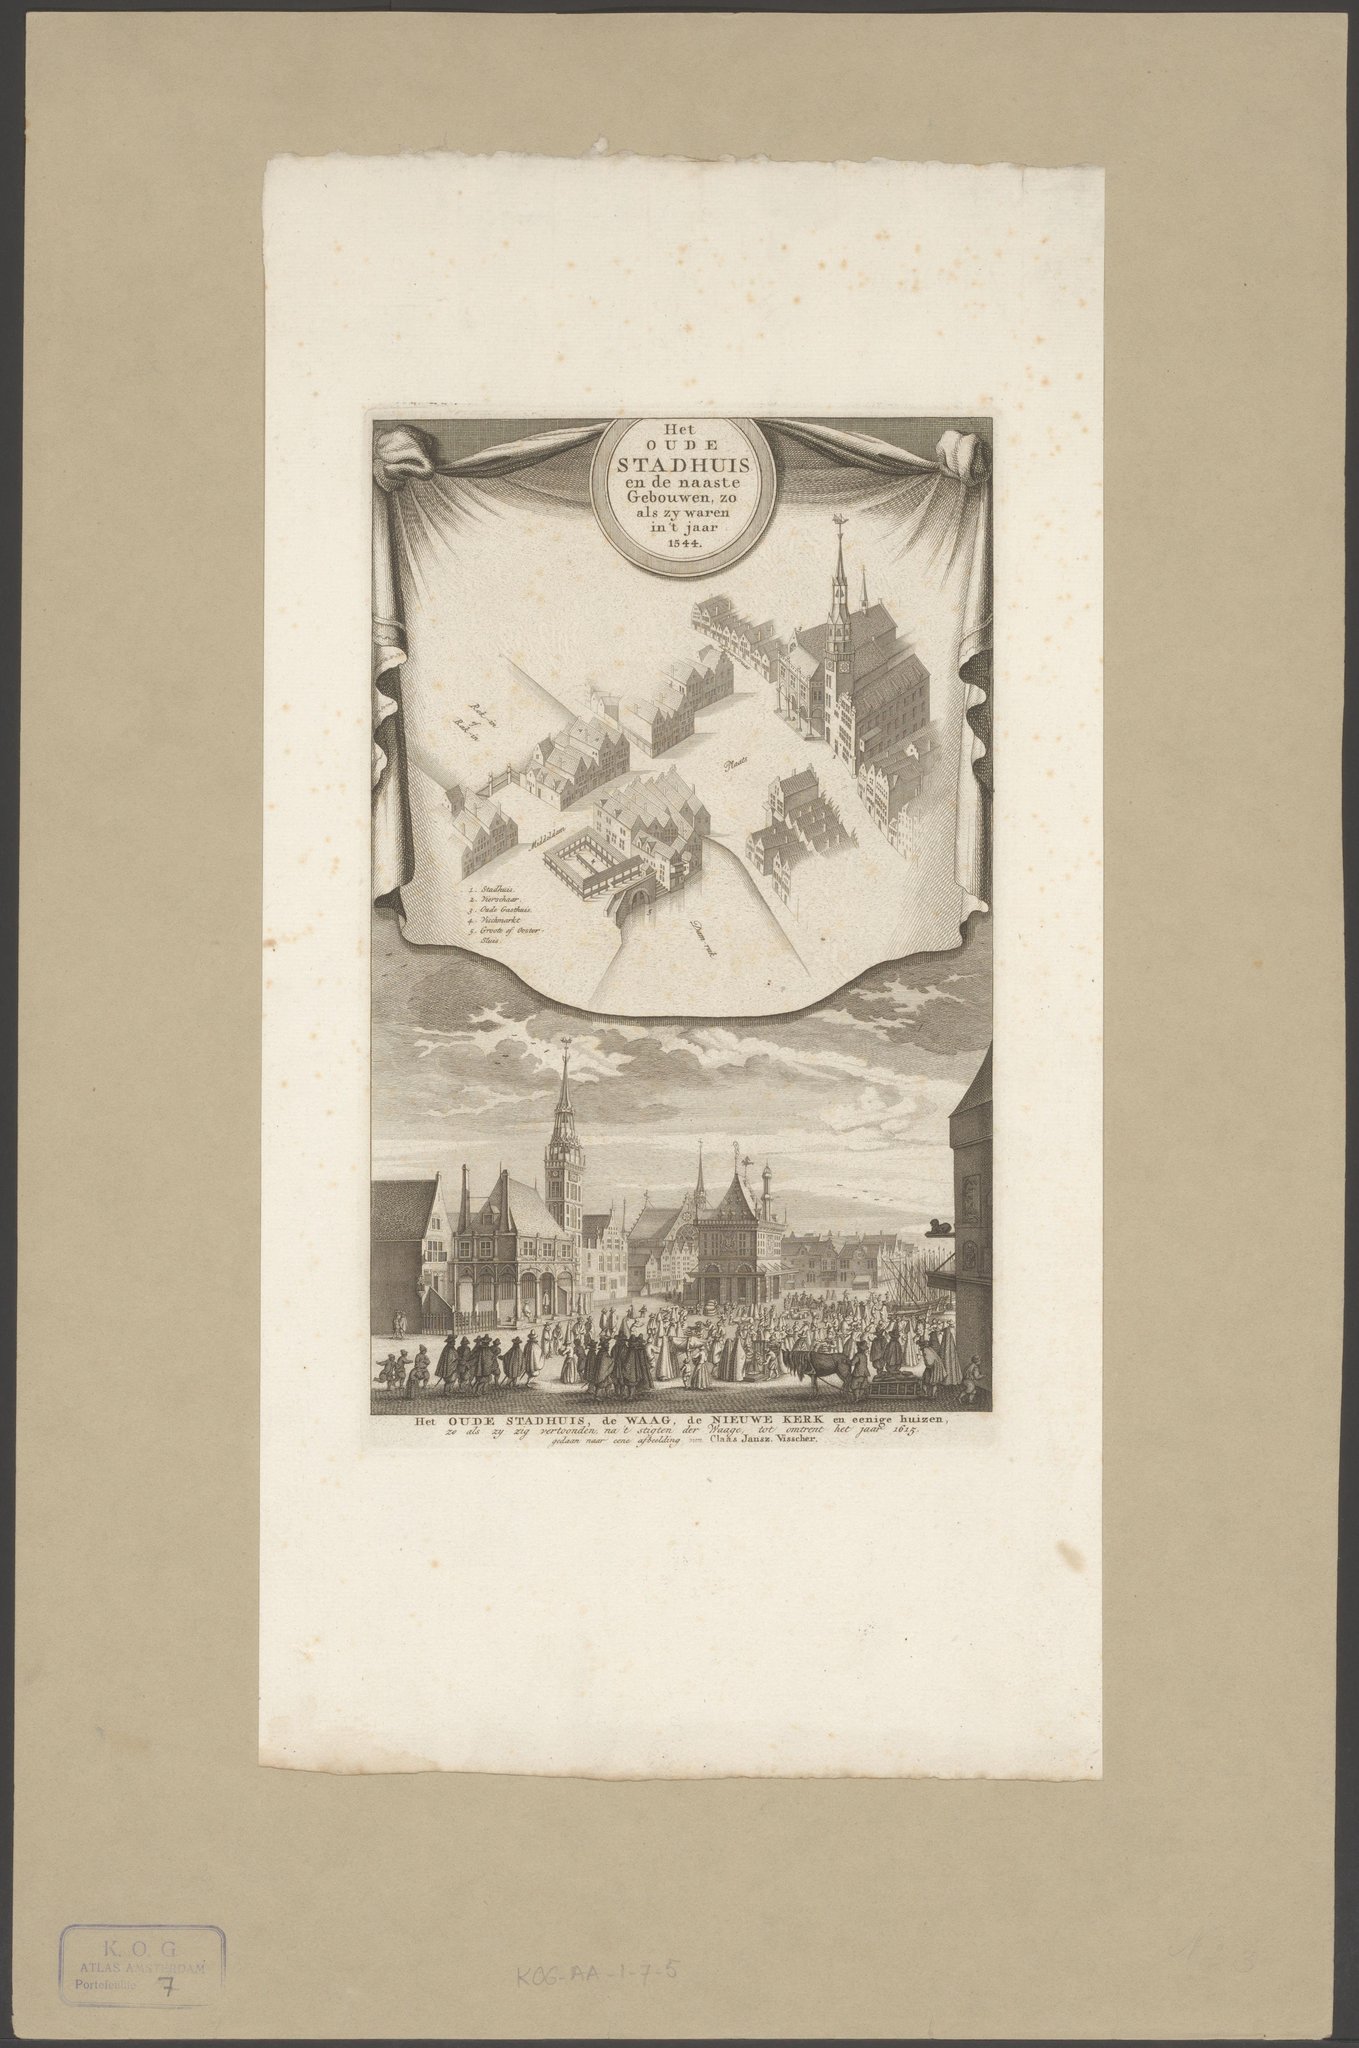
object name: print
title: Het Oude Stadhuis en de naaste gebouwen, zo als zy waren in 't jaar 1544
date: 1760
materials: paper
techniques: etching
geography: amsterdam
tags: square, place, circus, etc., city-view in general; 'veduta', church (exterior), townhall, weigh-house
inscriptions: collector's mark: ‘7’ Lugt 1641b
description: Prent uit: Wagenaar, Jan. Amsterdam, in zyne opkomst, aanwas geschiedenissen, voorregten, koophandel, gebouwen, kerkenstaat, schoolen, schutterye, gilden en regeeringe, beschreven door Jan Wagenaar, historieschryver de Stad. Amsterdam: Isaak Tirion, 1760. De vogelvluchtvoorstelling is gebaseerd op de kaart van Cornelis Anthoniszoon uit 1544.